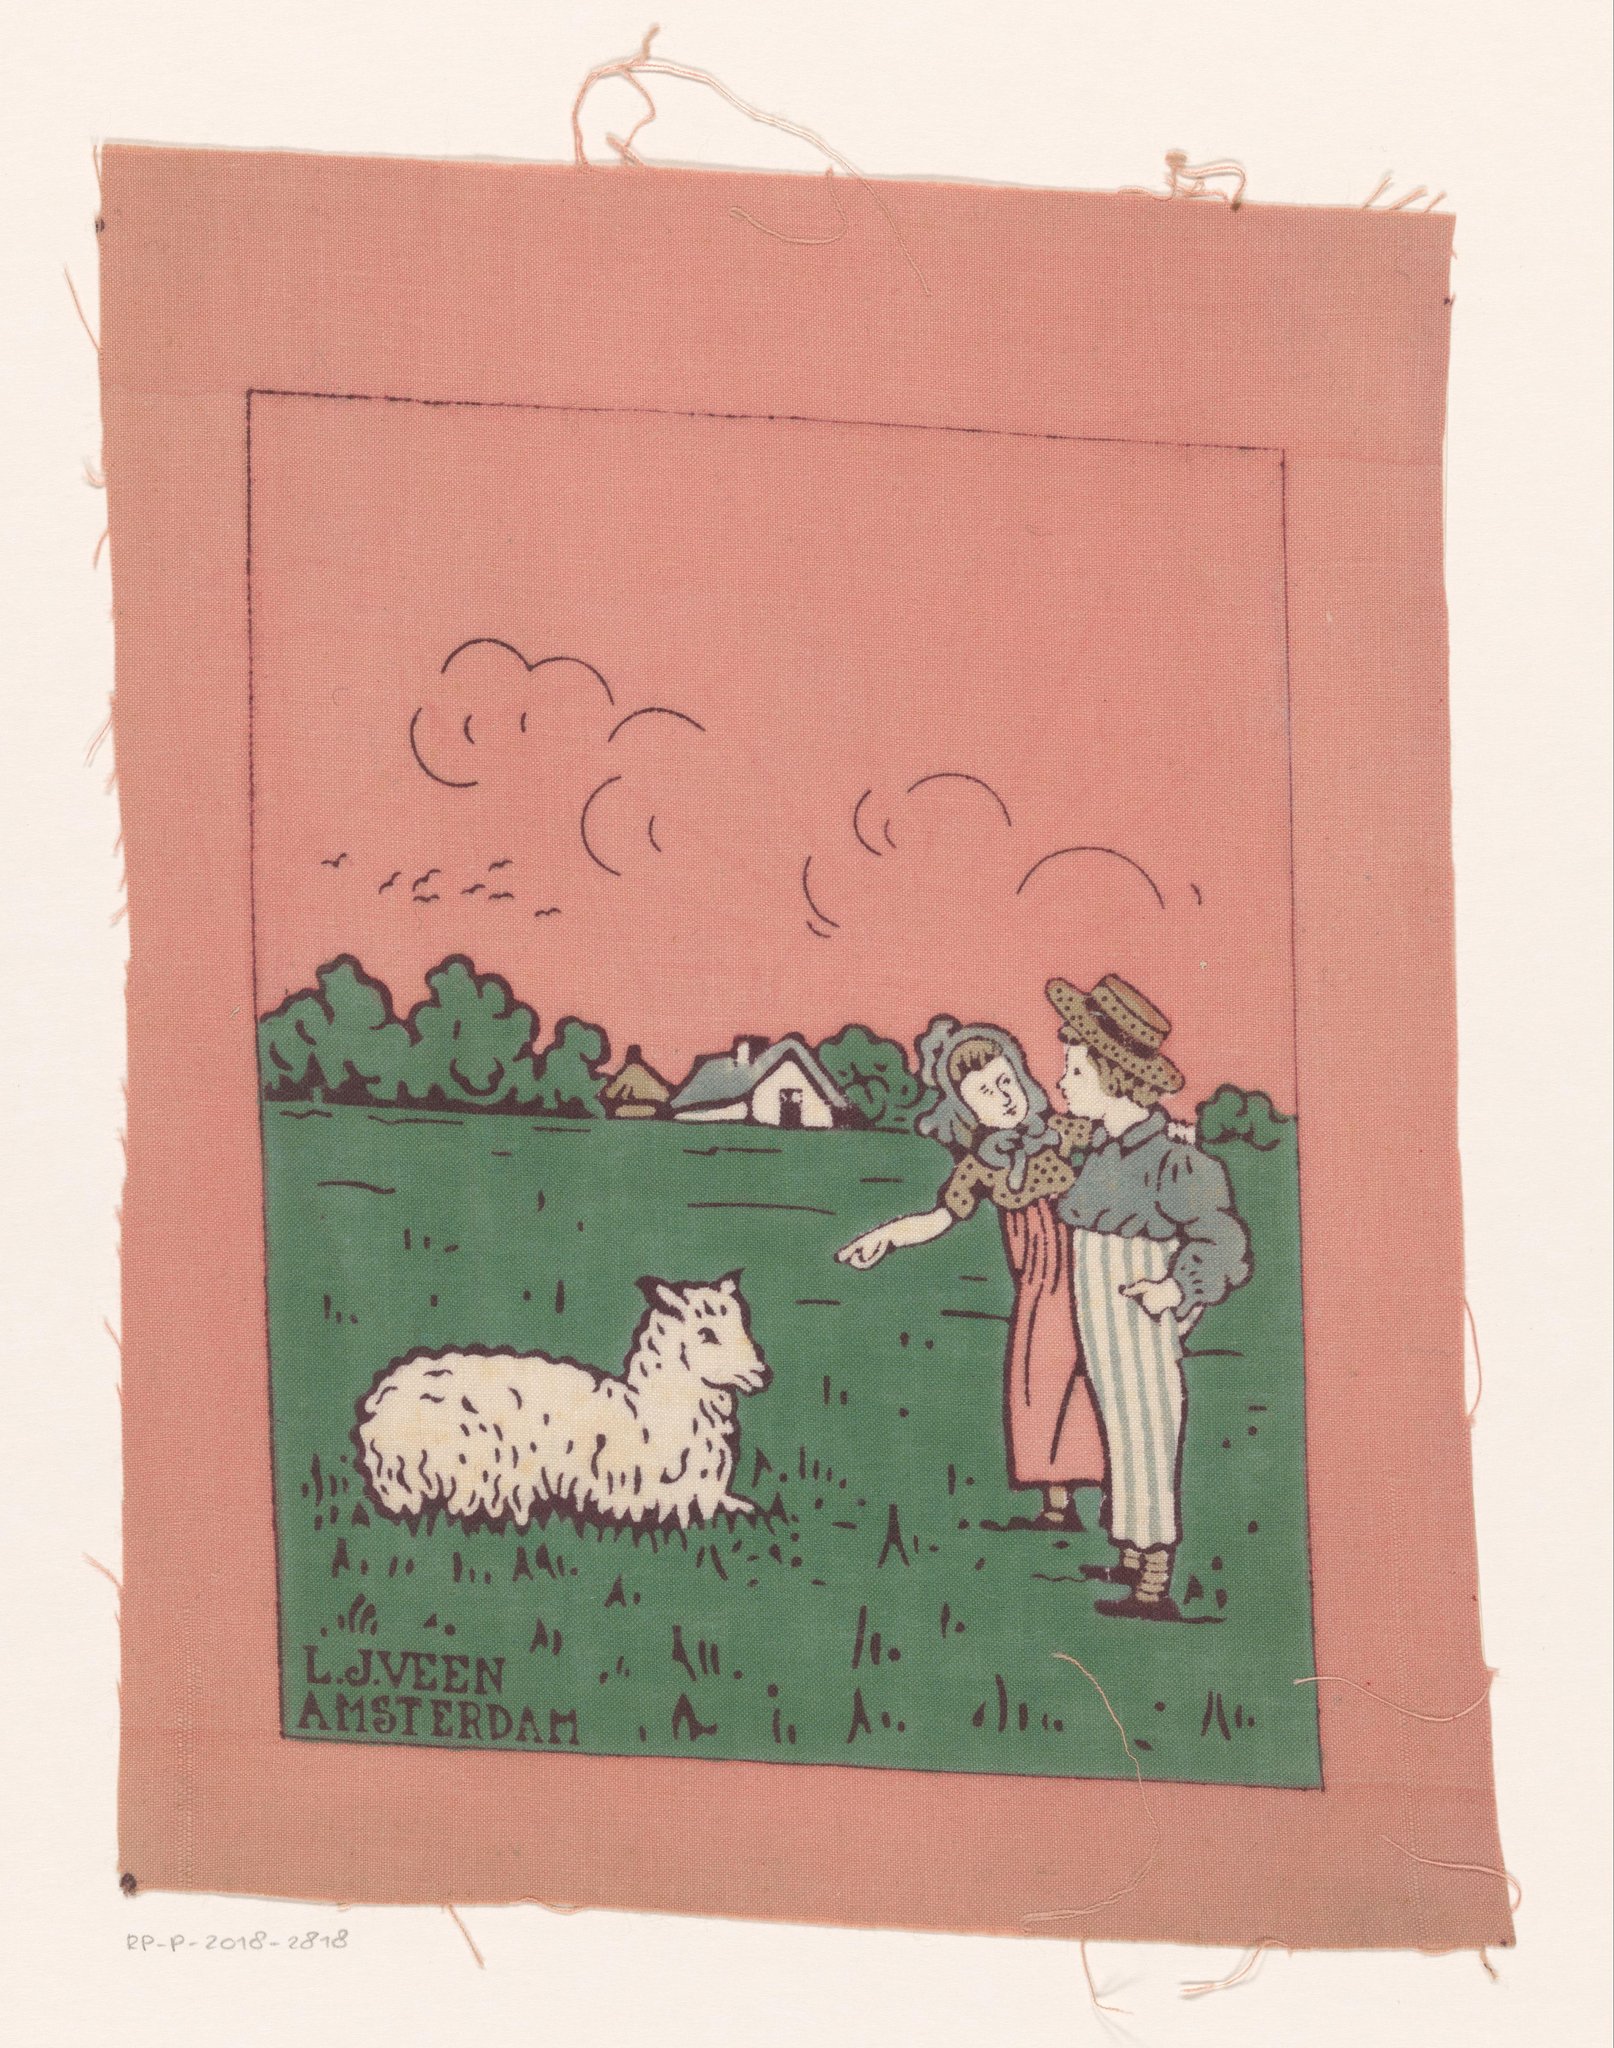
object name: study for binding design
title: Jongen, meisje en schaap in een weiland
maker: Anonymous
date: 1890-1920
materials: ink, linen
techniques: printing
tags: boy (child between toddler and youth), girl (child between toddler and youth), sheep, farm or solitary house in landscape (+ city(-scape) with figures, staffage)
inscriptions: collector's mark: Lugt 2228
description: Een jongen en meisje staan in een weiland bij een schaap. Het meisje heeft haar hand over de schouder van de jongen geslagen en wijst met de andere hand naar het schaap. In de verte een huis.